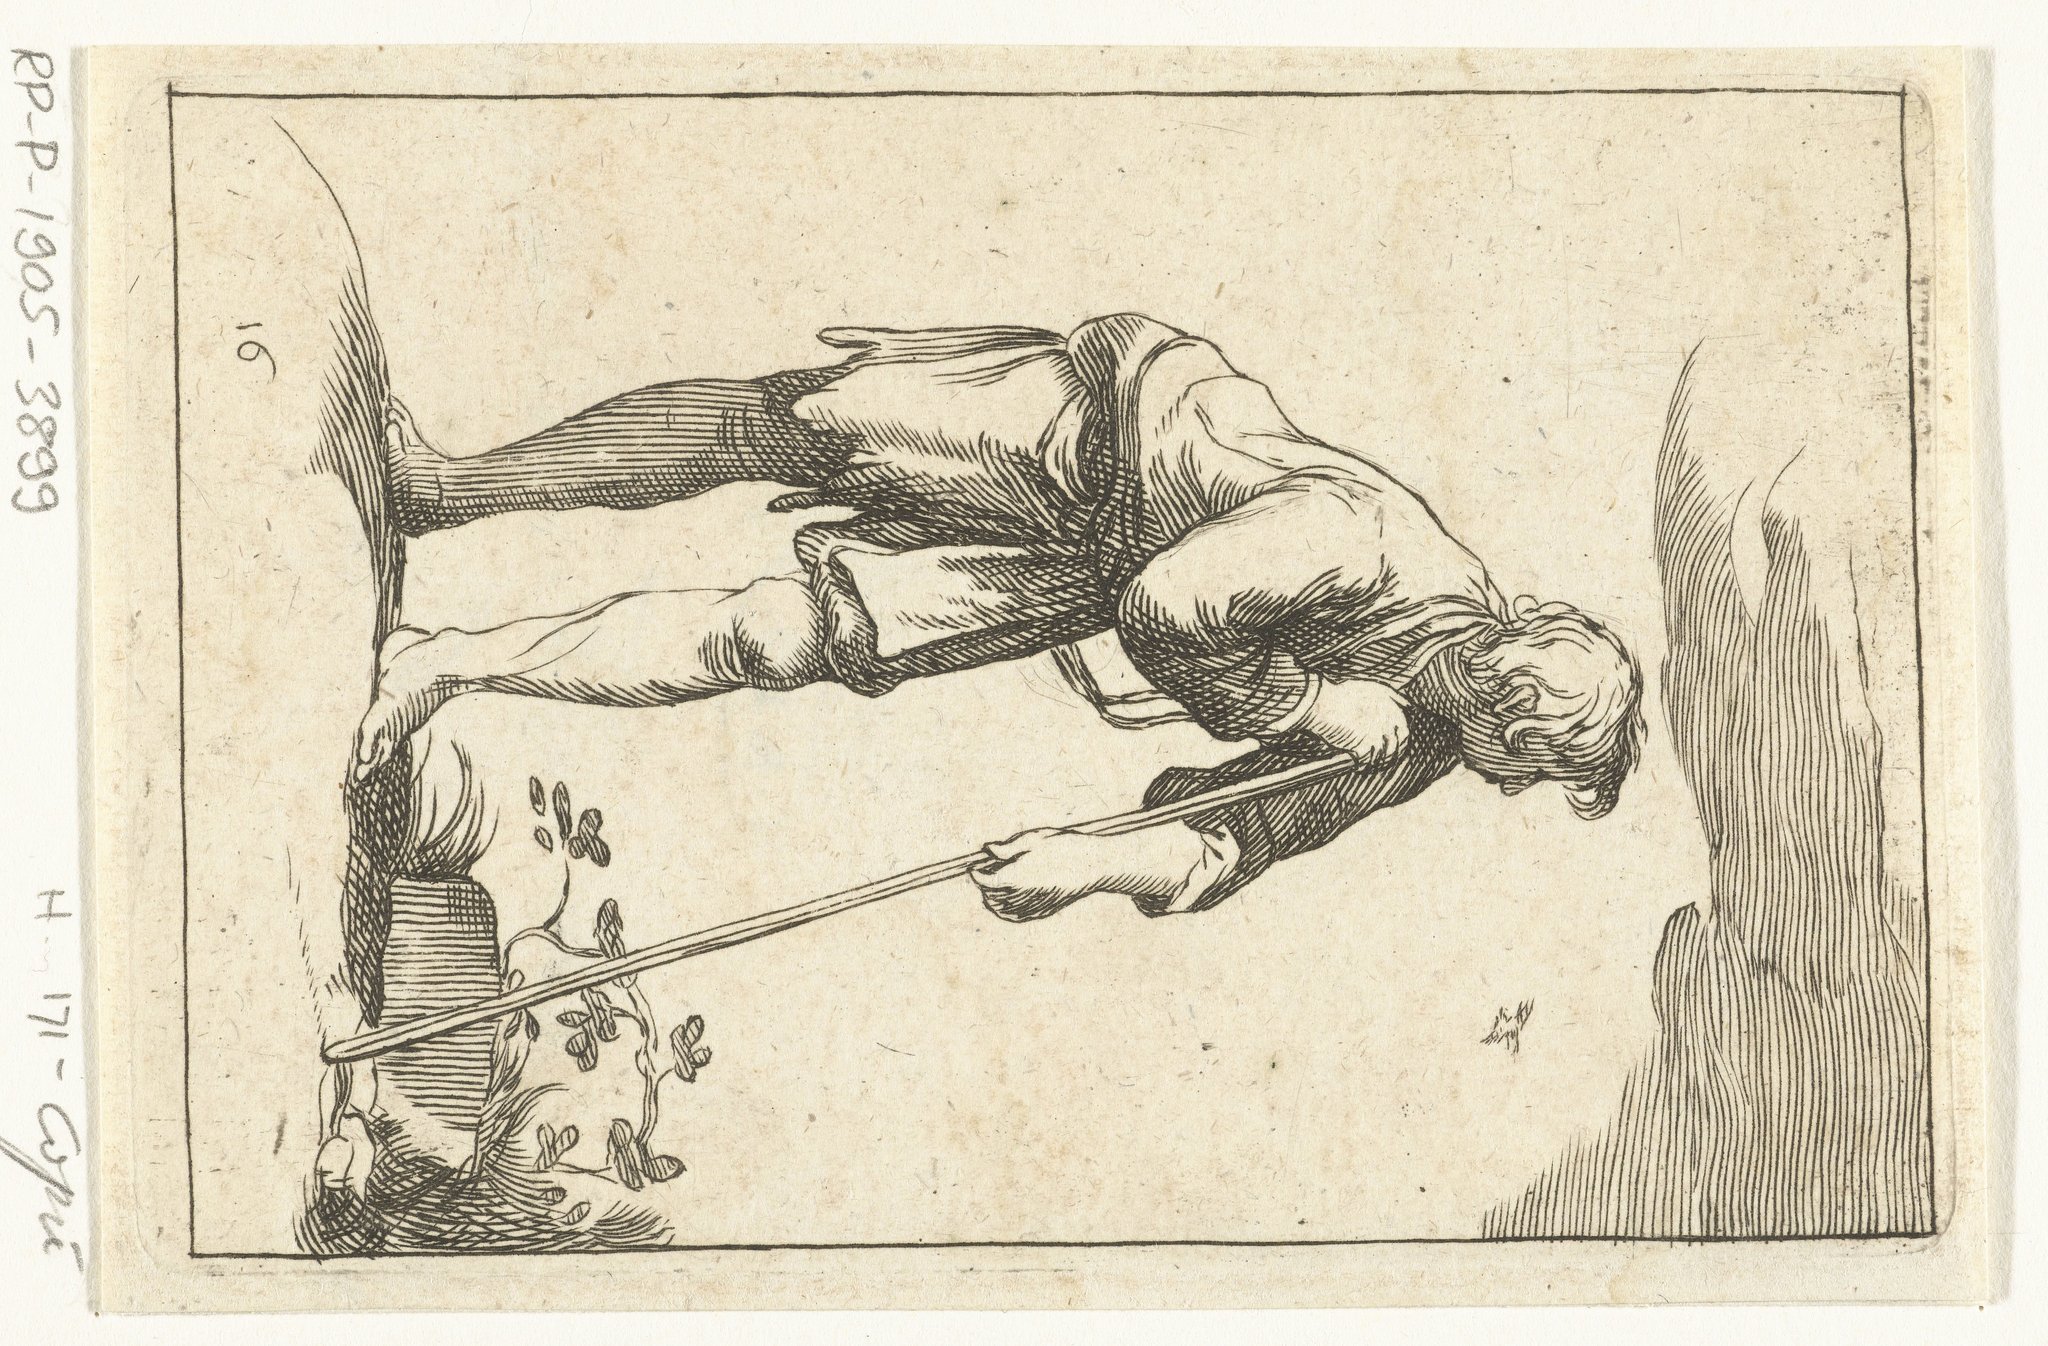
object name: print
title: Jonge boer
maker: Anonymous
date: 1635-1709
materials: paper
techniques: engraving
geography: netherlands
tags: farmers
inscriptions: collector's mark: Lugt 2228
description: Een jongeman leunt voorovergebogen over een stok naast een bloemperkje.